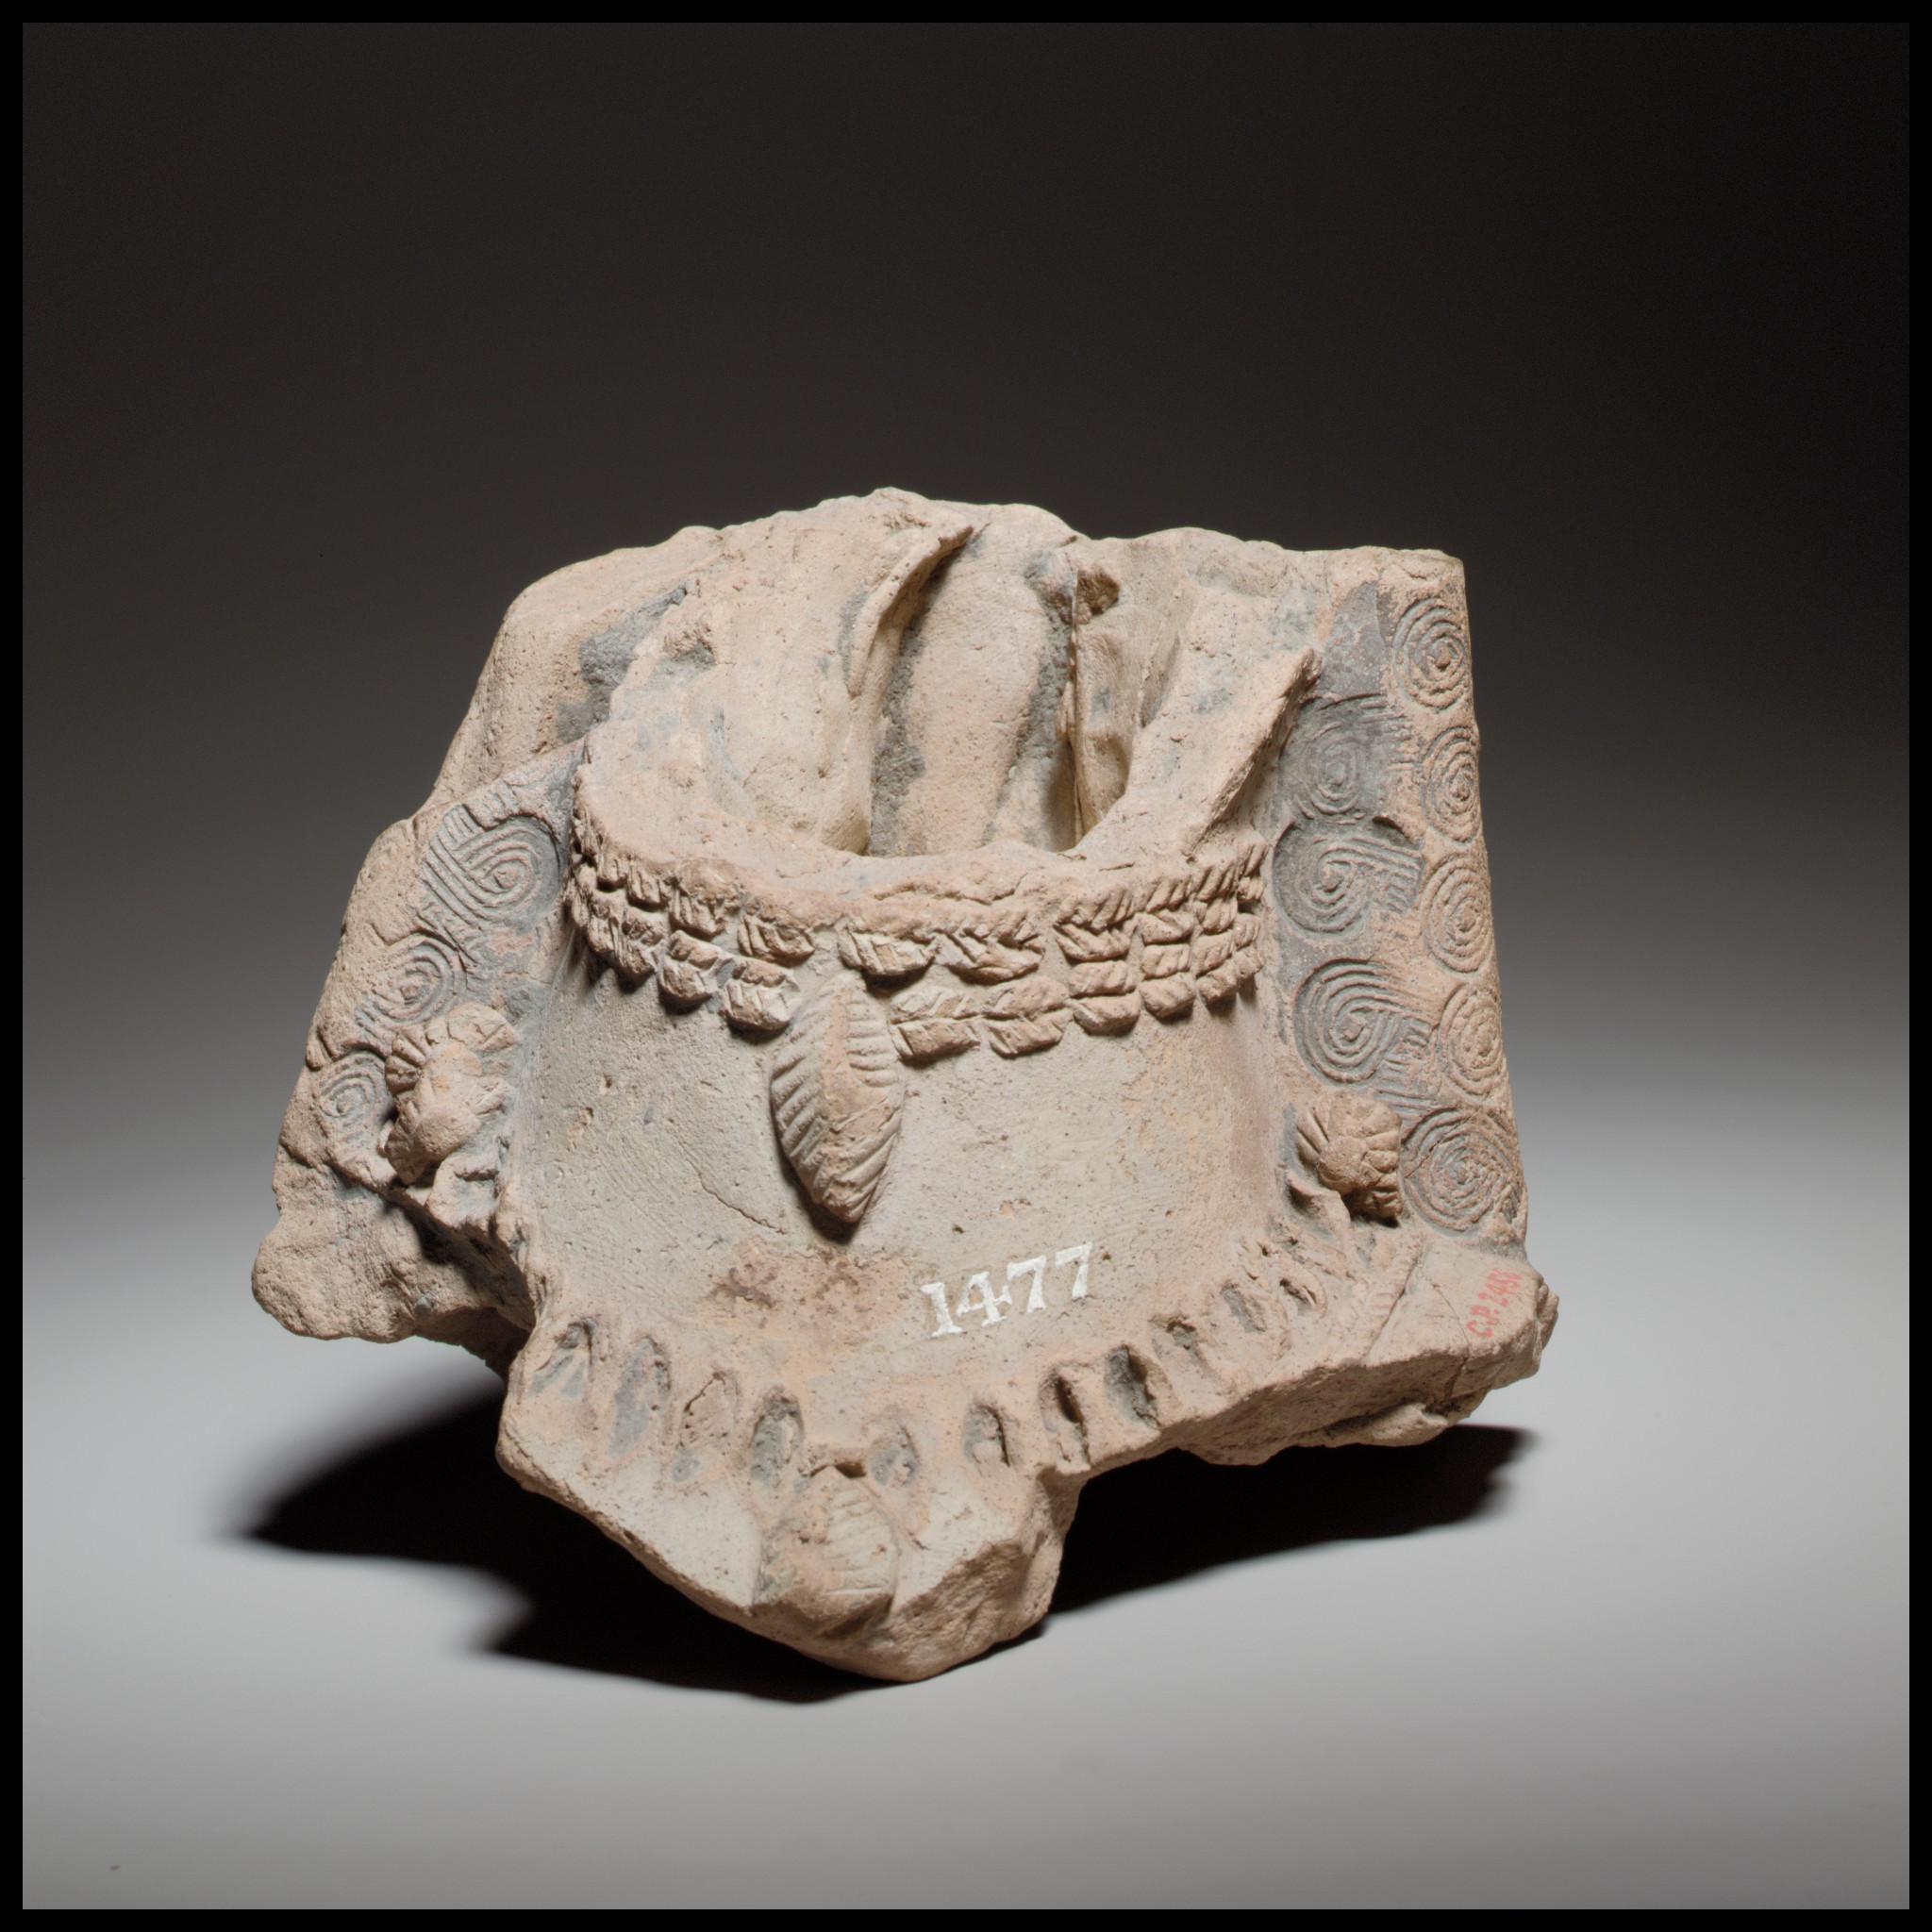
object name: statue of a woman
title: Fragment of a terracotta female figure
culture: cypriot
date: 600 BCE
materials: terracotta